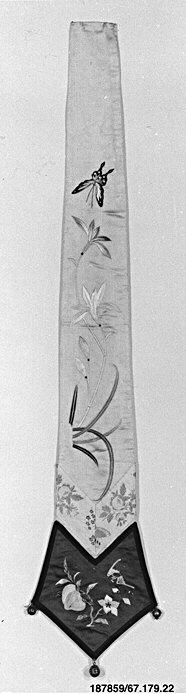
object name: streamer from dancer's costume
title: Streamers From Dancer's Costume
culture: chinese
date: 1801-1900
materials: bronze, silk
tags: butterflies,flowers